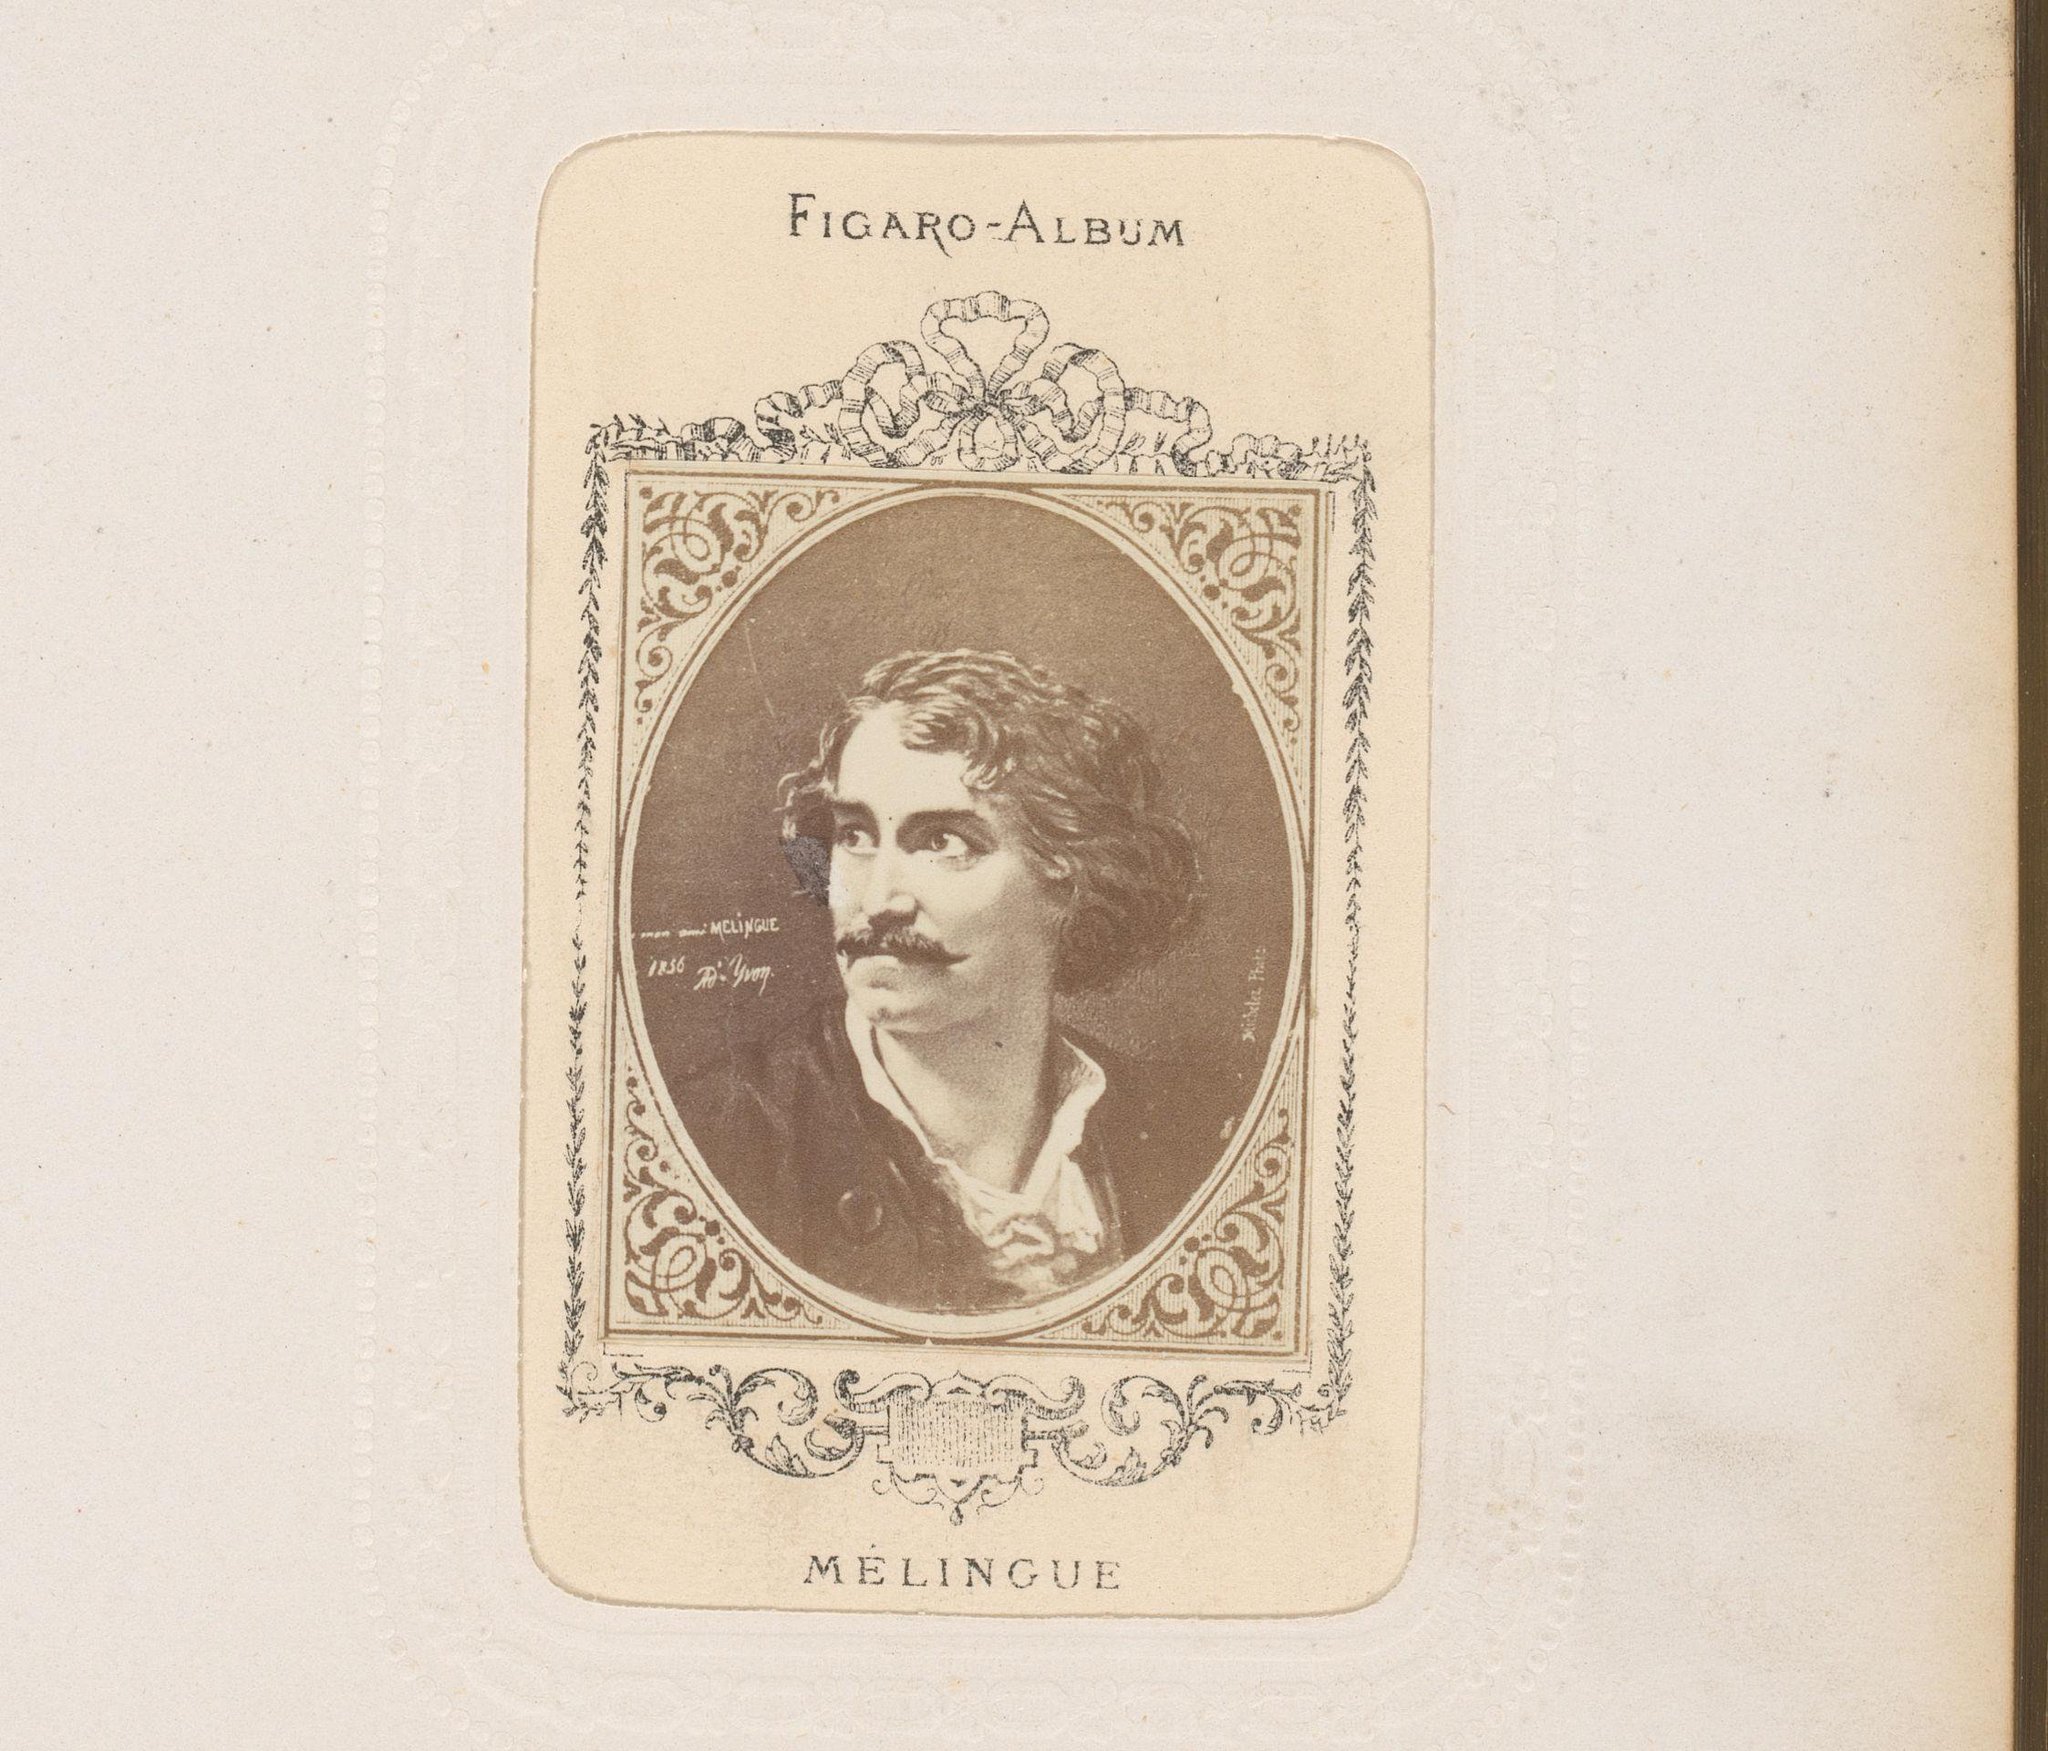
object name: album leaf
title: Fotoreproductie van een portret van Étienne Marin Mélingue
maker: Anonymous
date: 1860-1900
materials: cardboard, photographic support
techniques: albumen print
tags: painter, sculptor, historical persons, portrait of actor, actress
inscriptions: inscription: ‘Figaro-Album/ Mélingue’